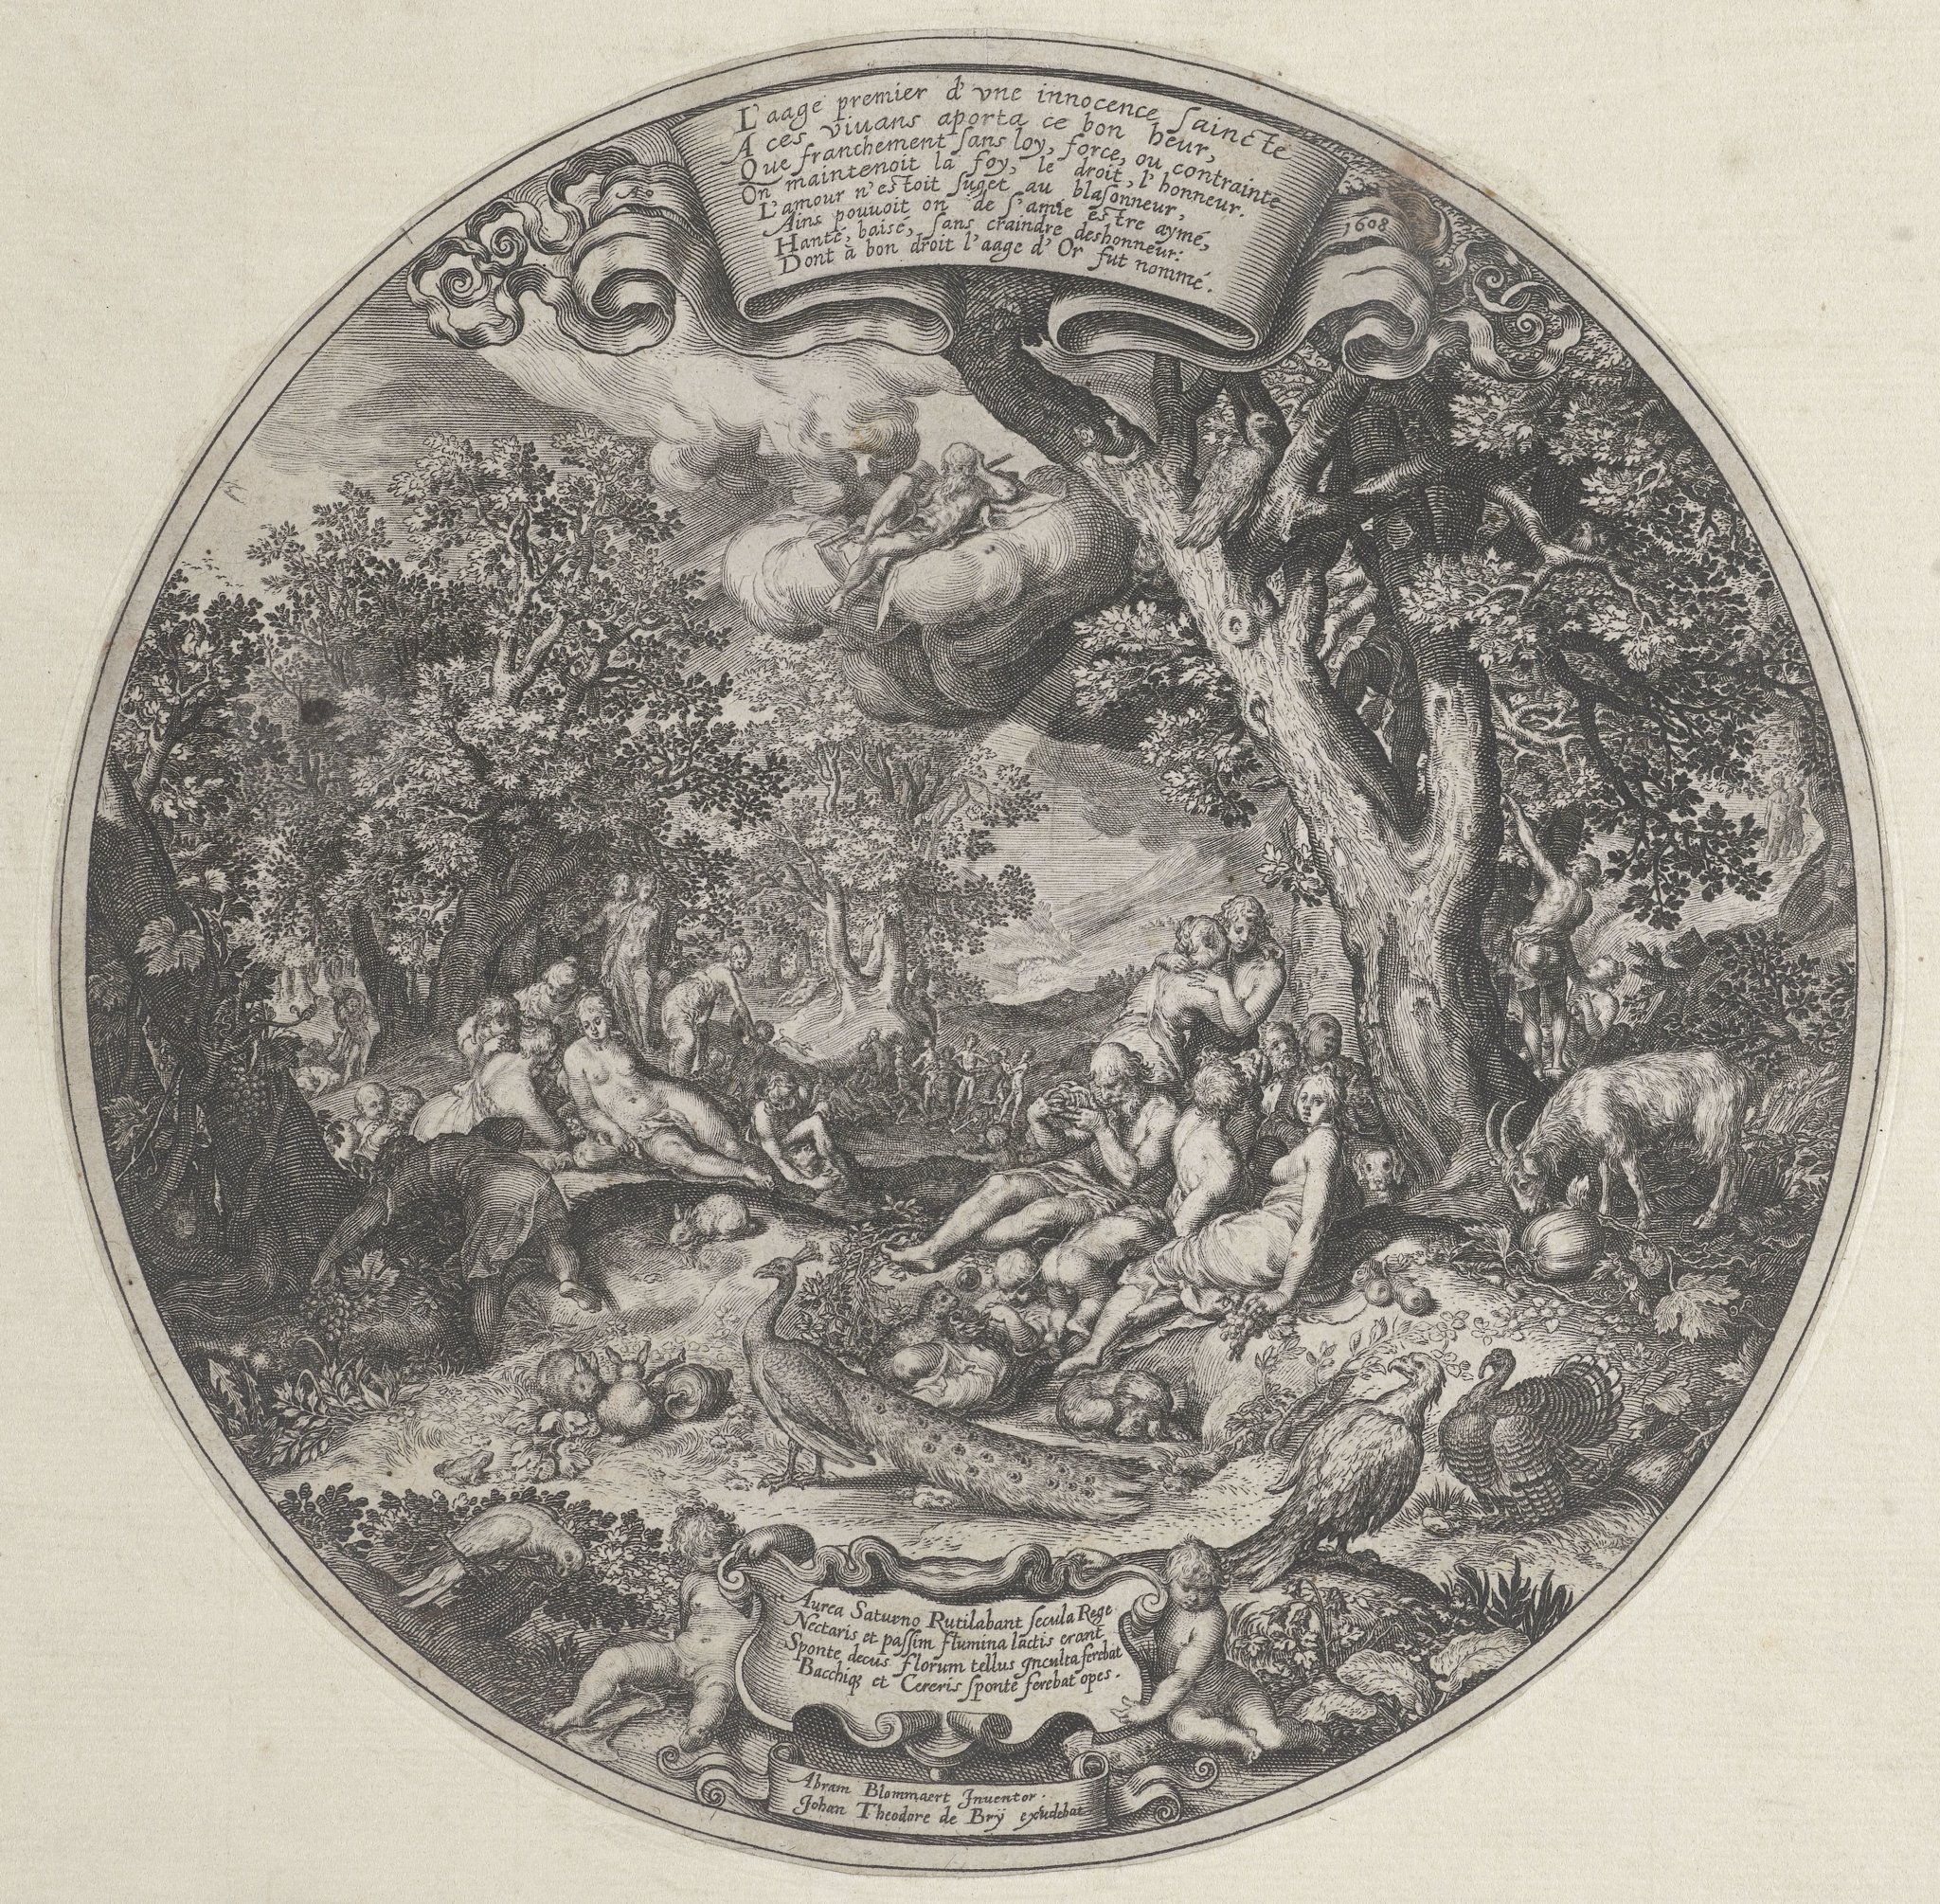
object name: print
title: Het Gouden Tijdperk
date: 1608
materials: paper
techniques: engraving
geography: frankfurt am main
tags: the golden age, 'aetas aurea'; men live happily, gathering fruits under the reign of saturn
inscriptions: collector's mark: Lugt 240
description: Naar een gravure van Nicolaes de Bruyn uit 1604 (Hollst.129), naar een tekening van Abraham Bloemaert (1603). De Bry heeft t.o.v. de prent van De Bruyn enkele veranderingen aangebracht: valk en kalkoen toegevoegd en Franse tekst op banderol toegevoegd.